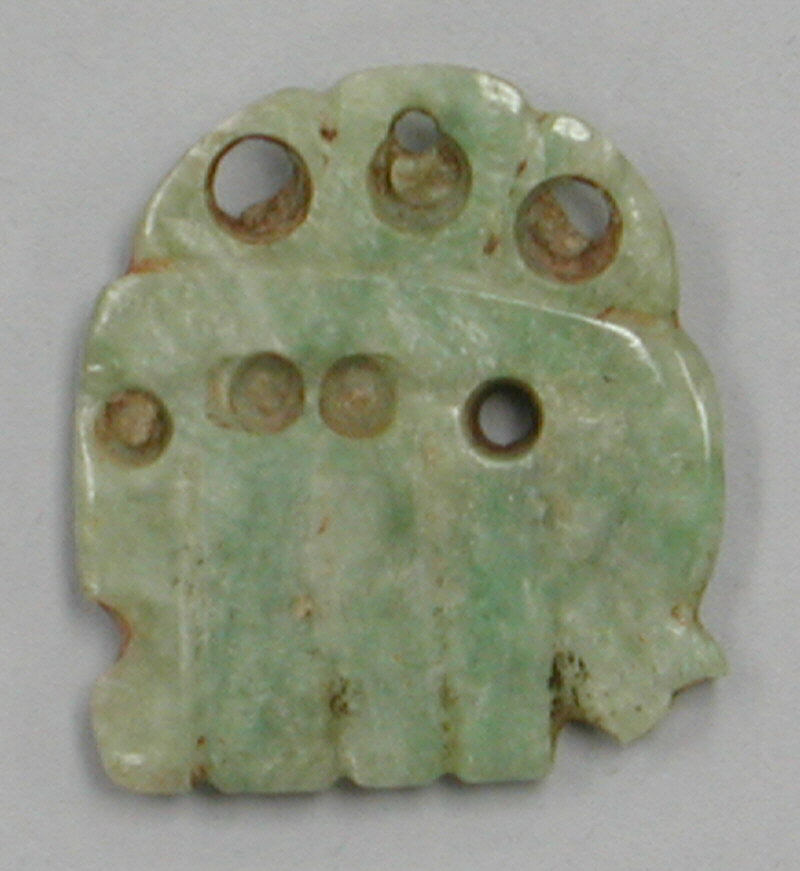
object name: inlay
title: Jade Inlay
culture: mexican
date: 1501-1600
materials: jade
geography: mexico